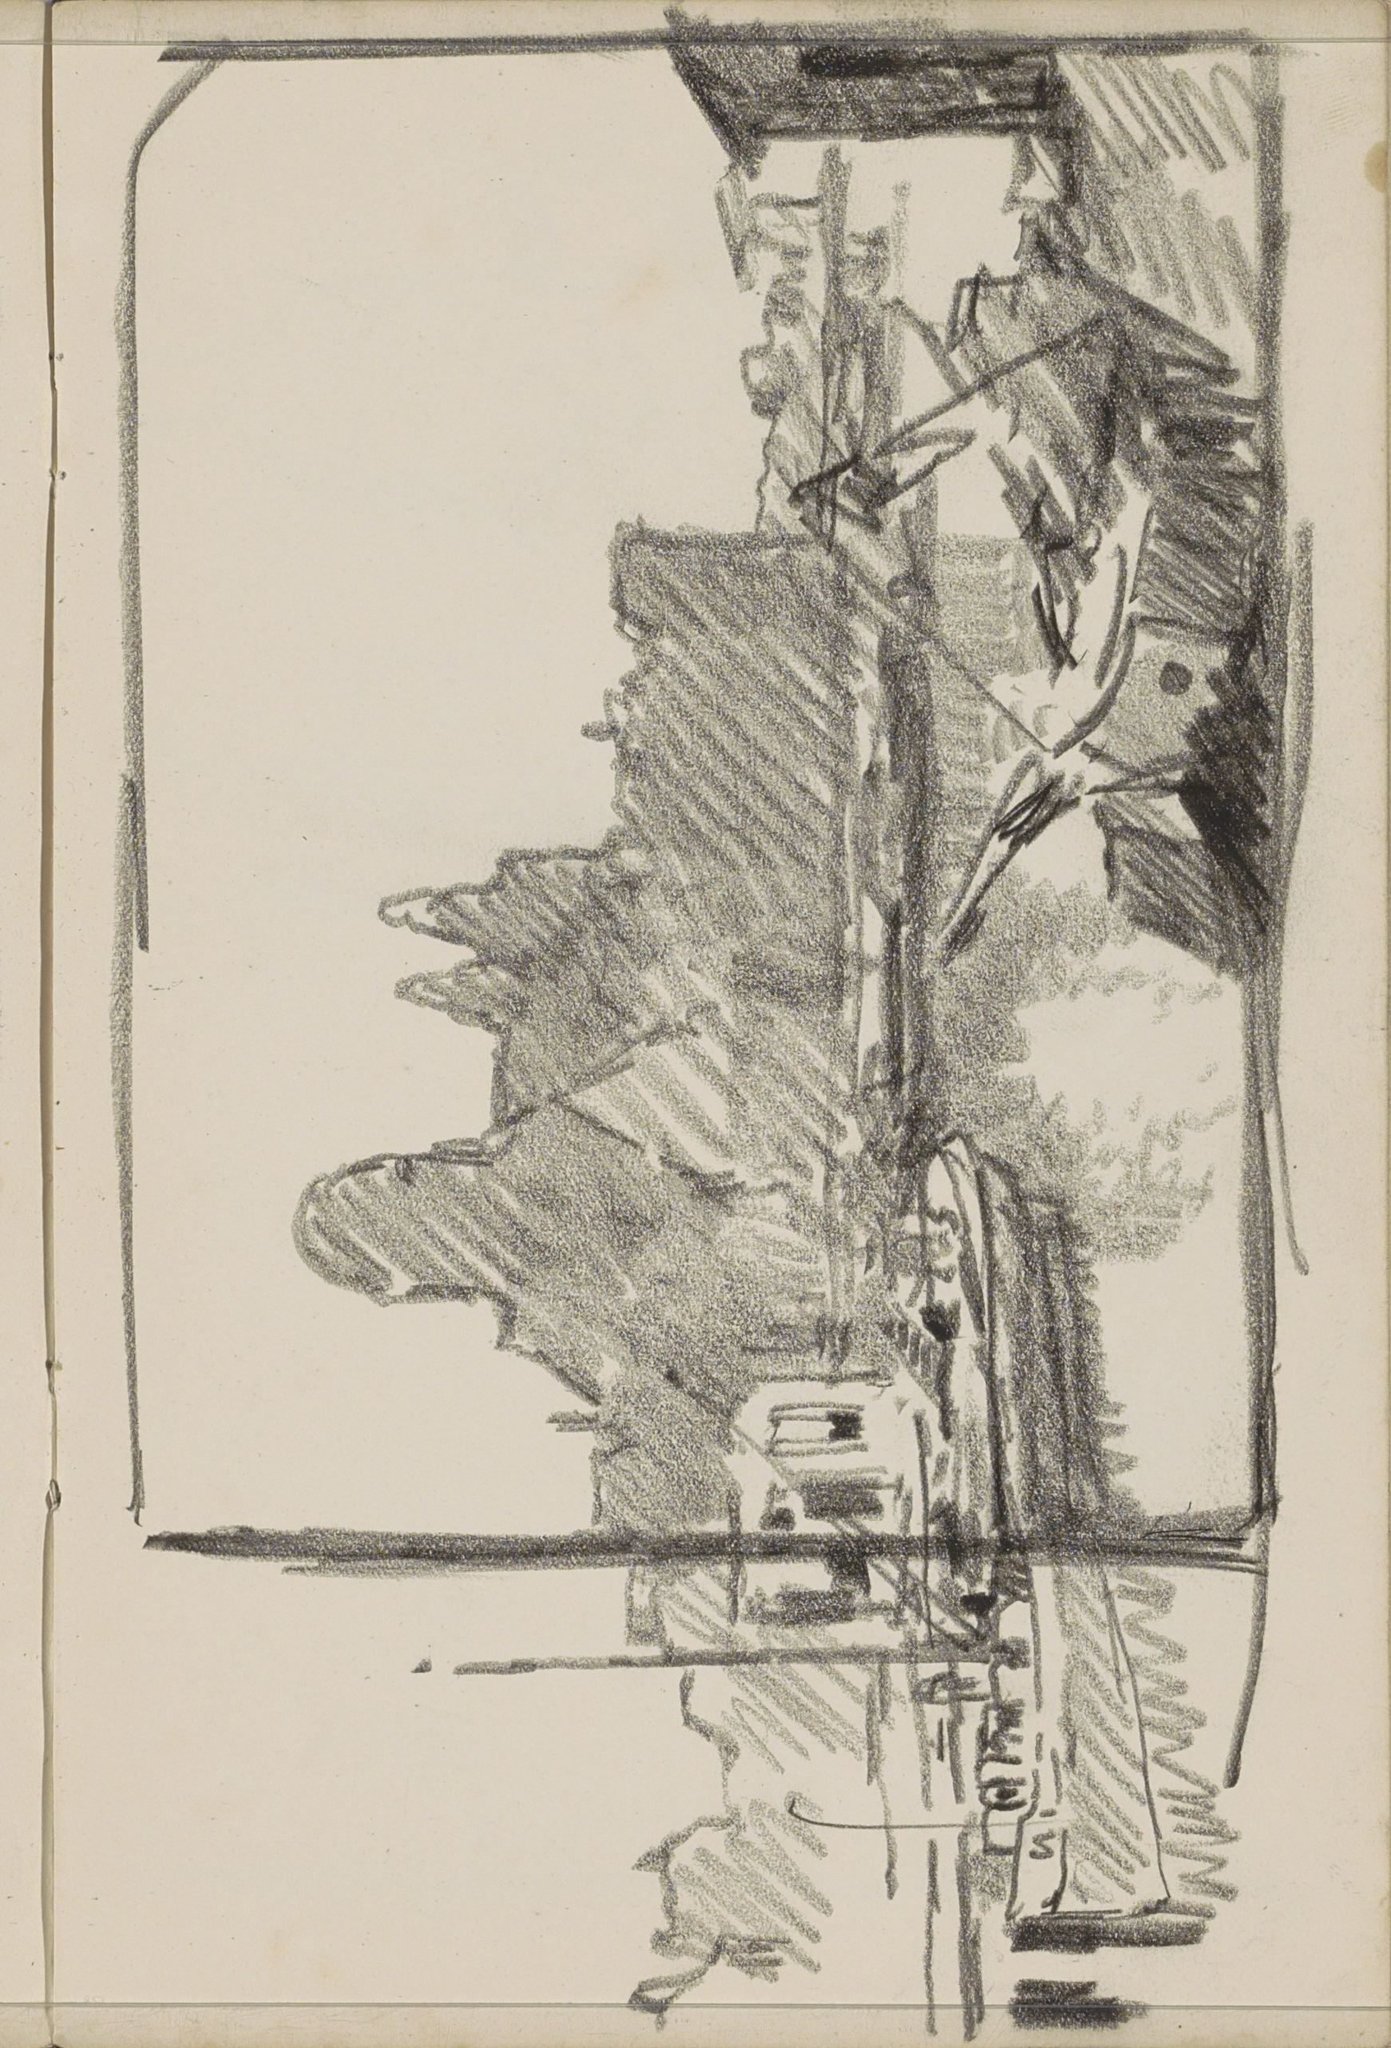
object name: sketchbook leaf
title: Boten op de Oudezijds Kolk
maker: cornelis vreedenburgh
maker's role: draughtsman, print maker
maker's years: 1880-1946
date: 1890-1946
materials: chalk, paper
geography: amsterdam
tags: canals, waters (in city)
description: Vreedenburgh heeft een kader getekend om een deel van de voorstelling, vermoedelijk om een compositie voor een schilderij aan te geven.